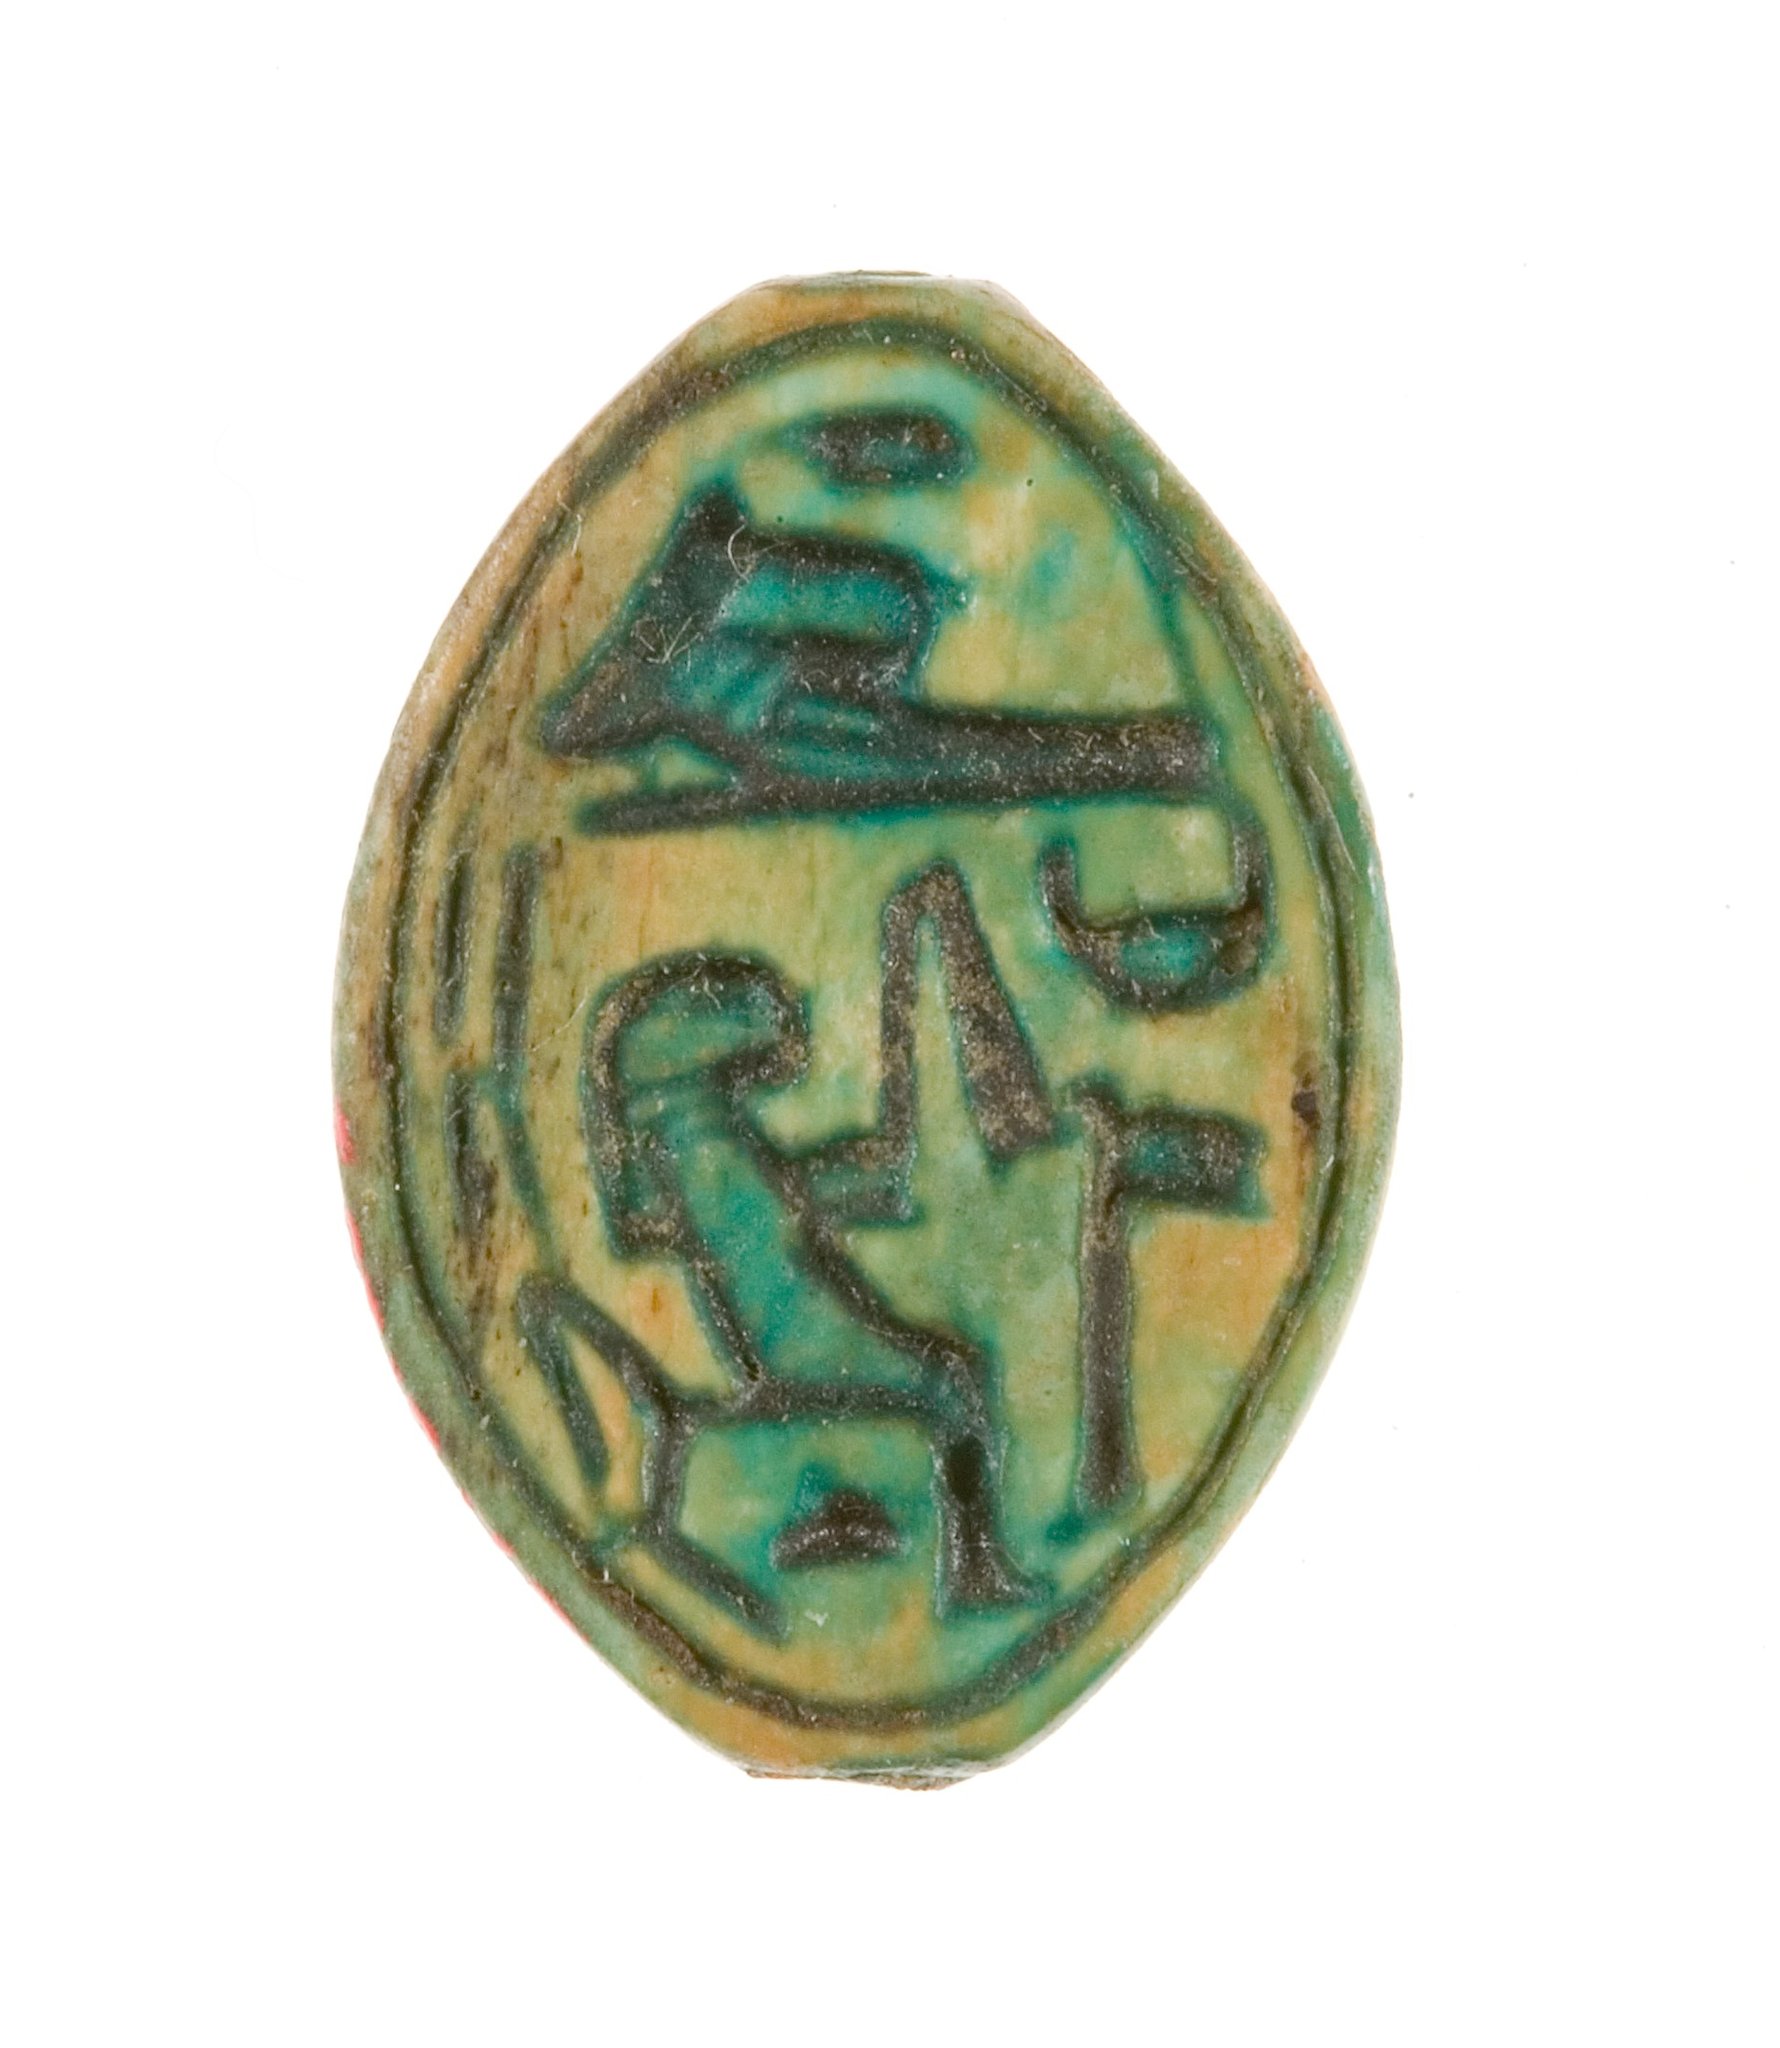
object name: cowroid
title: Cowroid Seal Amulet Inscribed for the God's Wife Hatshepsut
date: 1479-1458 BCE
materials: stone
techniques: glazing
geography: egypt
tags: hieroglyphs